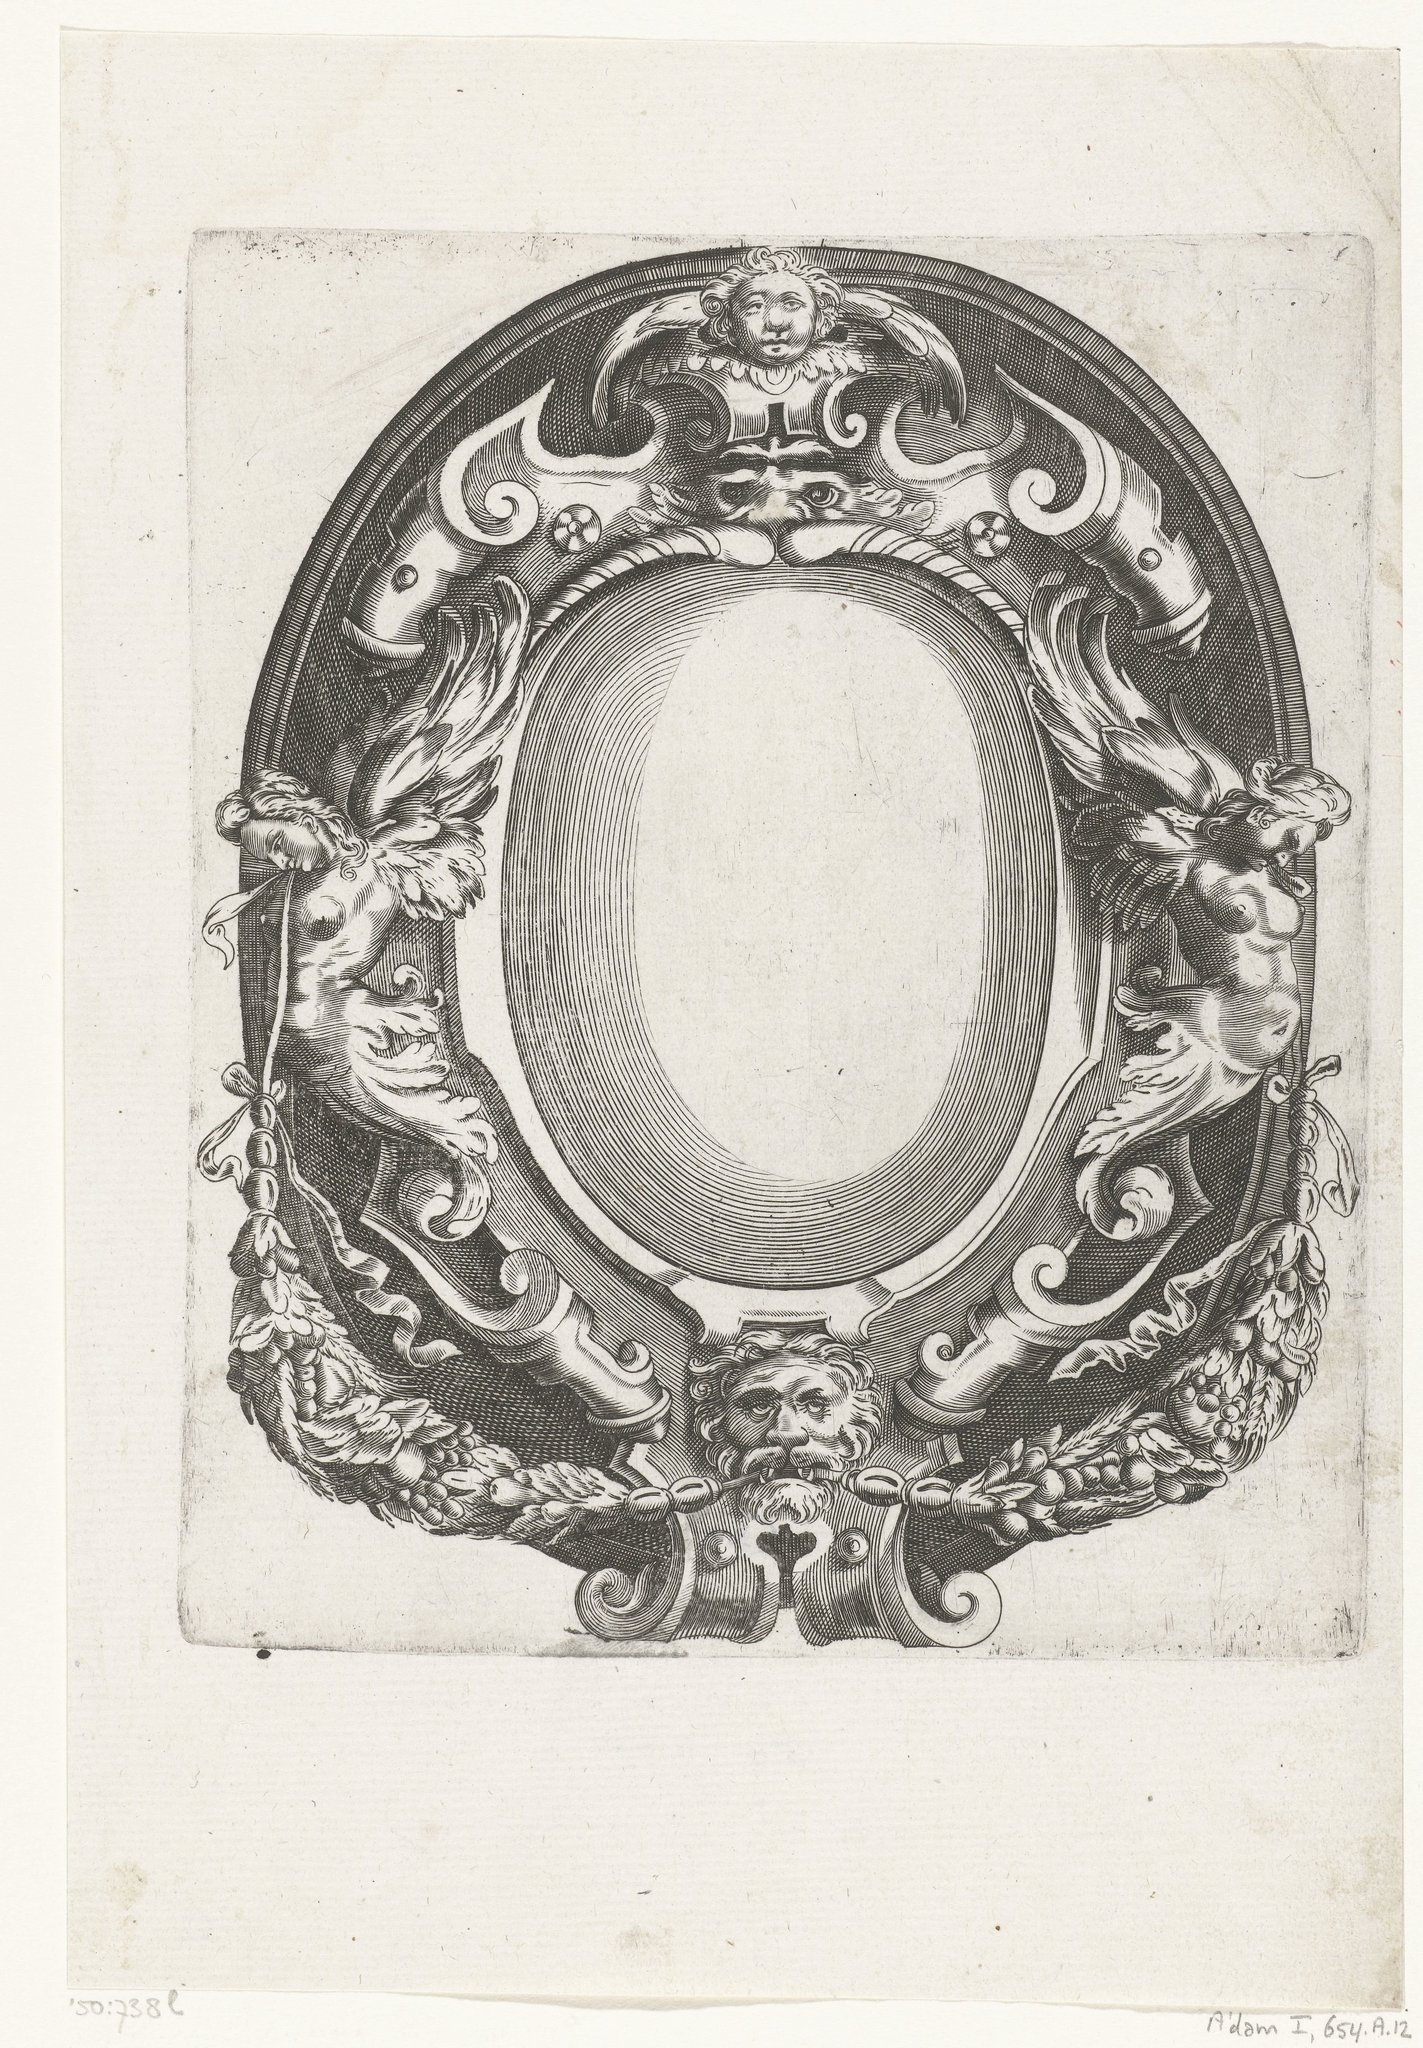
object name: ornament print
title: Cartouches in omlijstingen van rolwerk met grotesken, guirlandes en mascarons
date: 1628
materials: paper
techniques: engraving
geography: france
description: Links en rechts bevindt zich het bovenlichaam van een gevleugelde vrouw, zij heeft geen armen, maar houdt met haar mond het uiteinde van een guirlande vast. Tegenzijdige kopie naar blad 14 uit serie met cartouches in omlijstingen van rolwerk met grotesken, guirlandes en mascarons uitgegeven door Pierre Mariette.